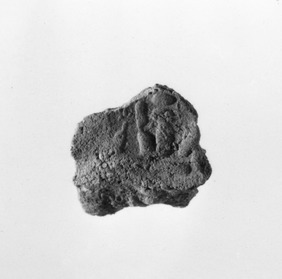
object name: sealing, nebmaatre, amenhotep iii, thoth, double crown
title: Document Sealing With the Throne Name of Amenhotep III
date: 1390-1352 BCE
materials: mud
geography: egypt